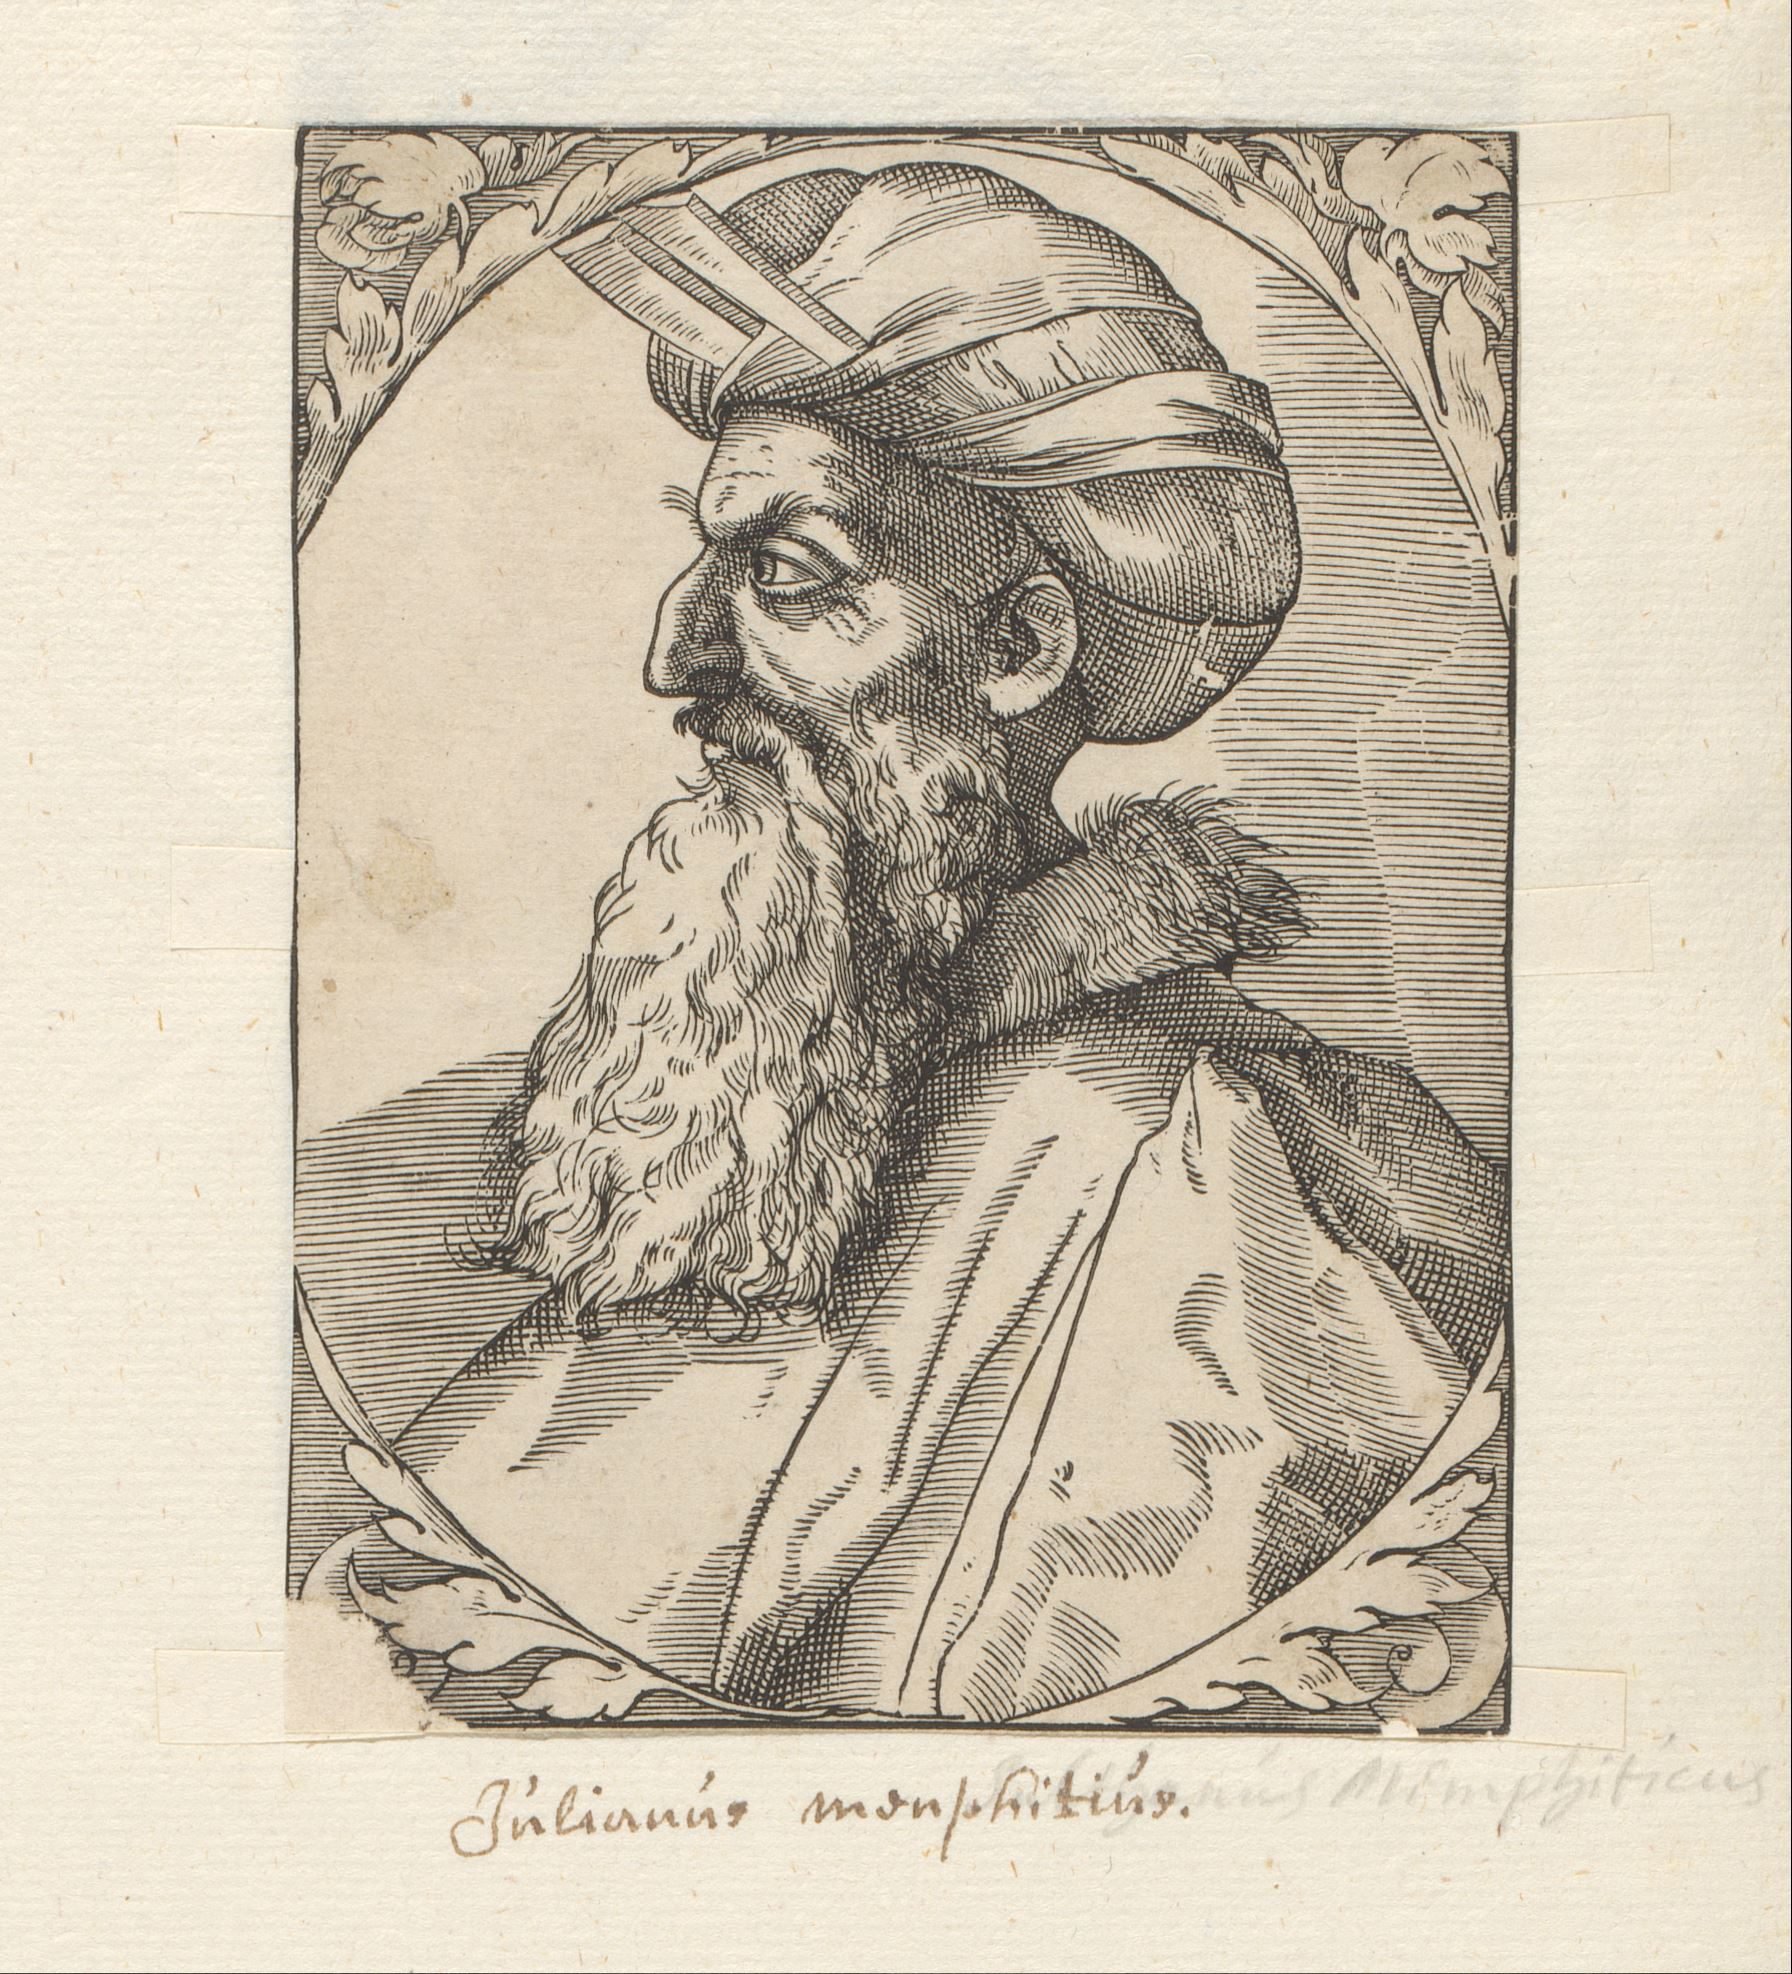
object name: album leaf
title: Portret van sultan Qaitbay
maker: Anonymous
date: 1549-1575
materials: paper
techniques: woodcut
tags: historical persons, ruler, sovereign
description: Prent gebruikt in: Giovio, Paolo. Elogia Virorum bellica virtute illustrium (...). Bazel: Peter Perna, 1575.